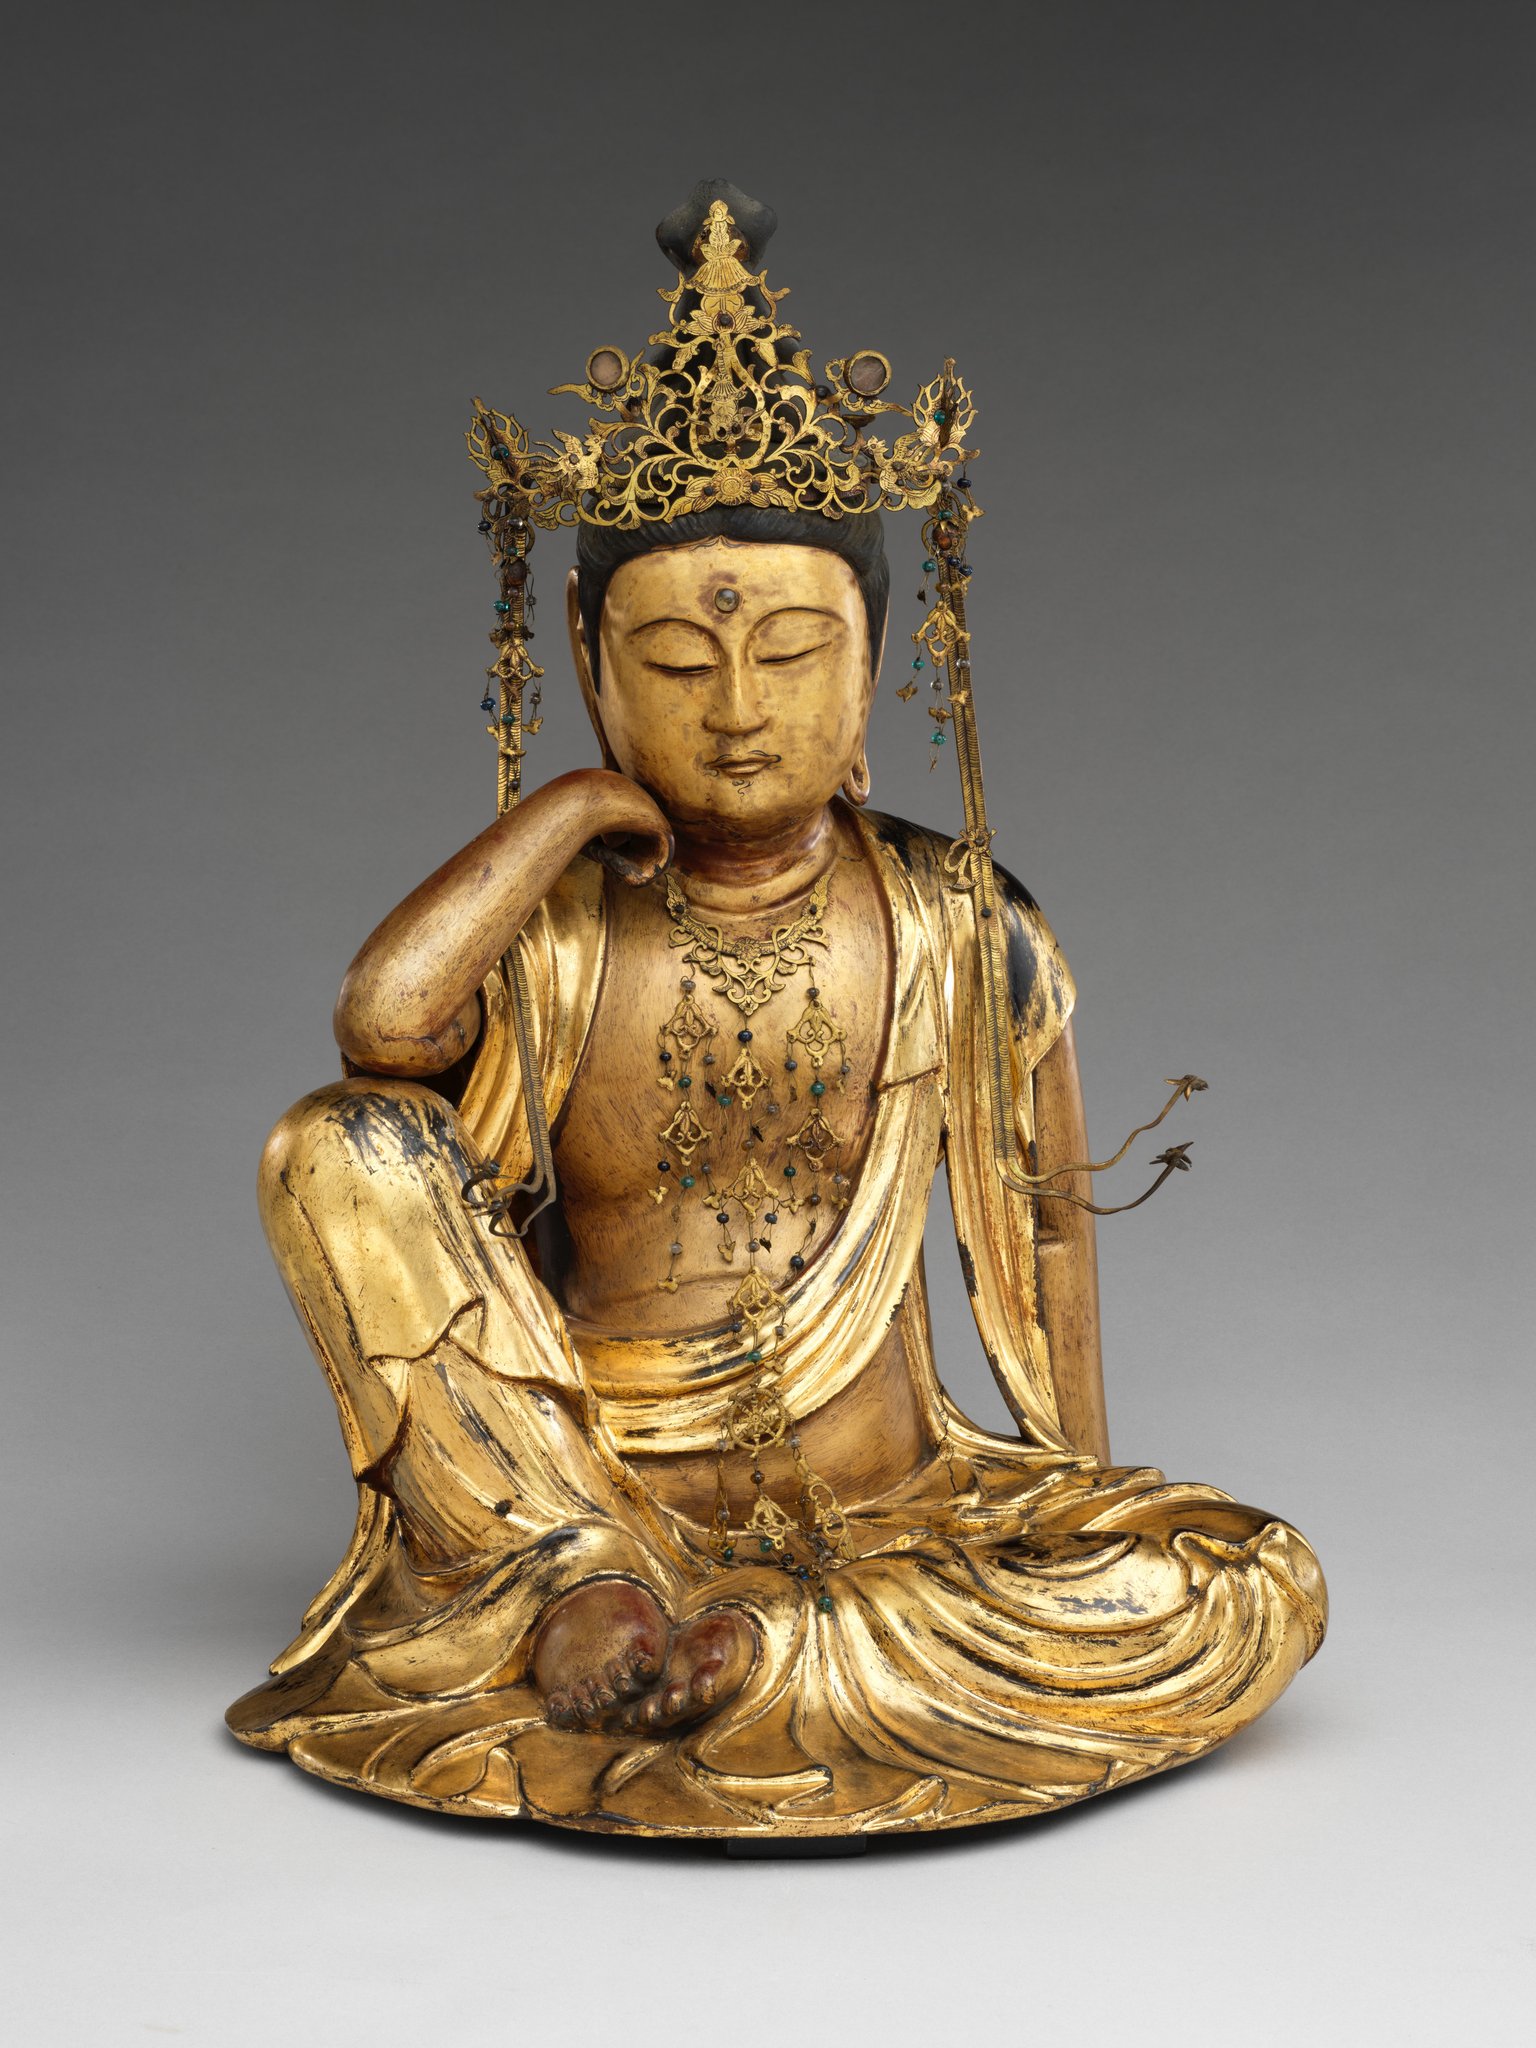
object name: figure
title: Nyoirin Kannon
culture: japanese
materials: crystal, gold, gold leaf, lacquer, wood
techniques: inlay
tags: buddhism,bodhisattvas